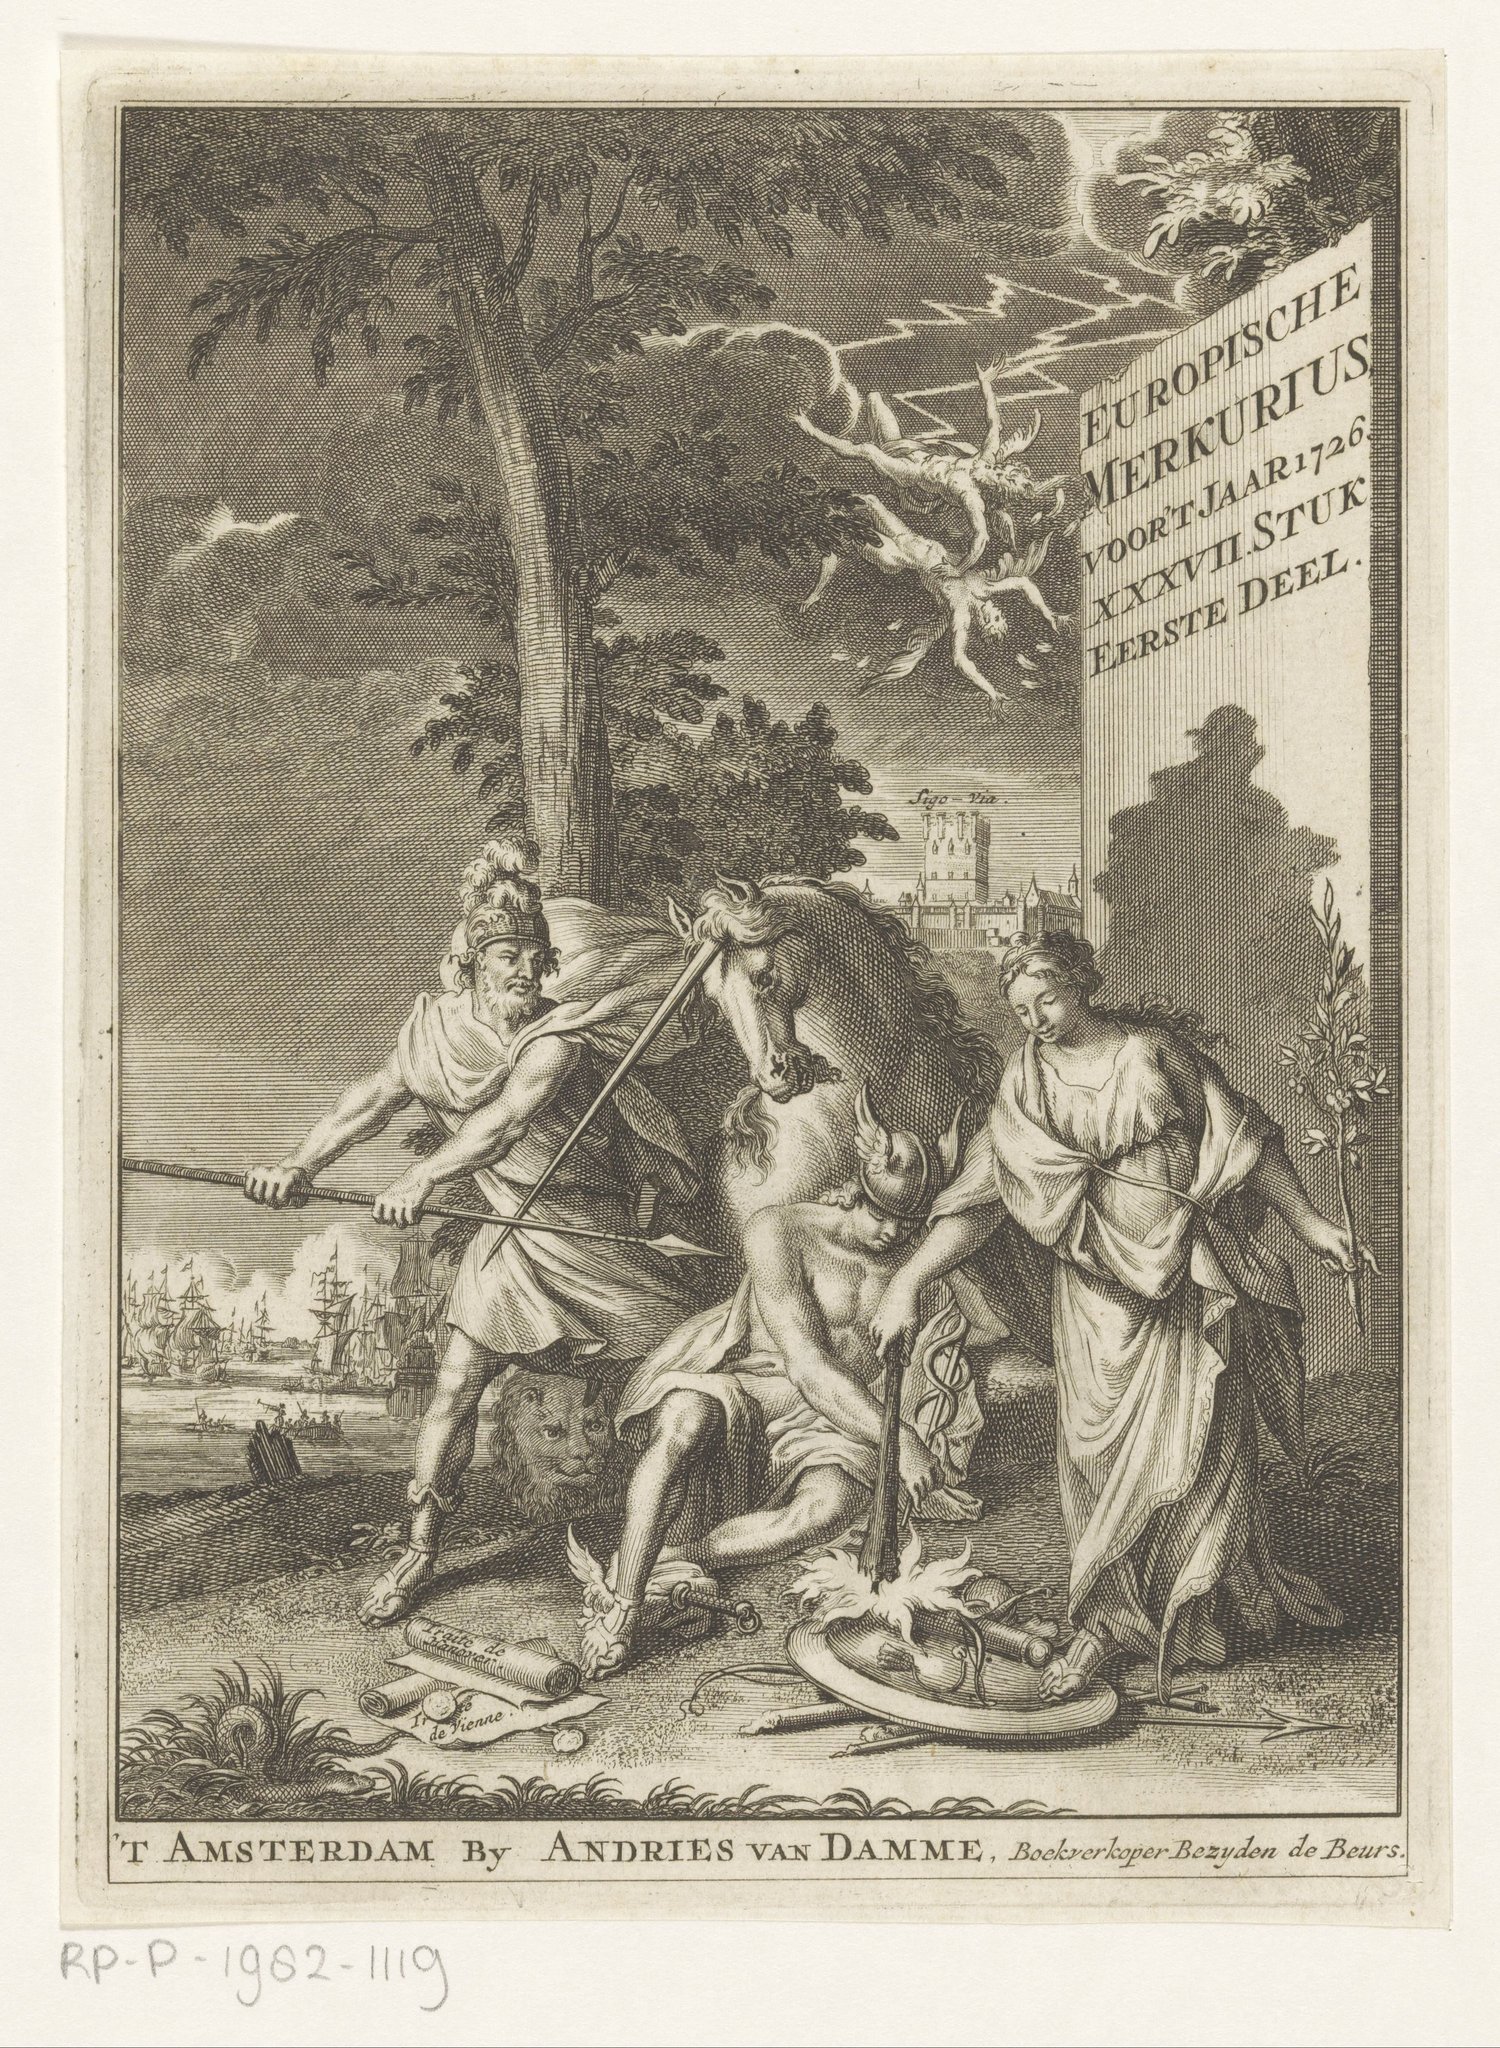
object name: print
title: Titelpagina voor: S.n., Europische Mercurius, 1726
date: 1726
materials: paper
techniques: engraving, etching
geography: amsterdam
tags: unicorn, symbols, allegories of peace, 'pax'; 'pace' (ripa), (story of) mercury (hermes), dream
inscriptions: collector's mark: Lugt 2228, stamp: ‘Doublet’, collector's mark: Lugt 2228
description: Mercurius zit te dromen. Naast hem staat de personificatie van de vrede, zij verbrandt wapens. Achter Mercurius probeert een soldaat de Vrede aan te vallen, maar wordt tegengehouden door een eenhoorn. Achter de soldaat een leeuw. In de achtergrond schepen op zee en de stad Segovia. Op de grond liggen traktaten van Hannover en Wenen. In de lucht twee vallende engelen.